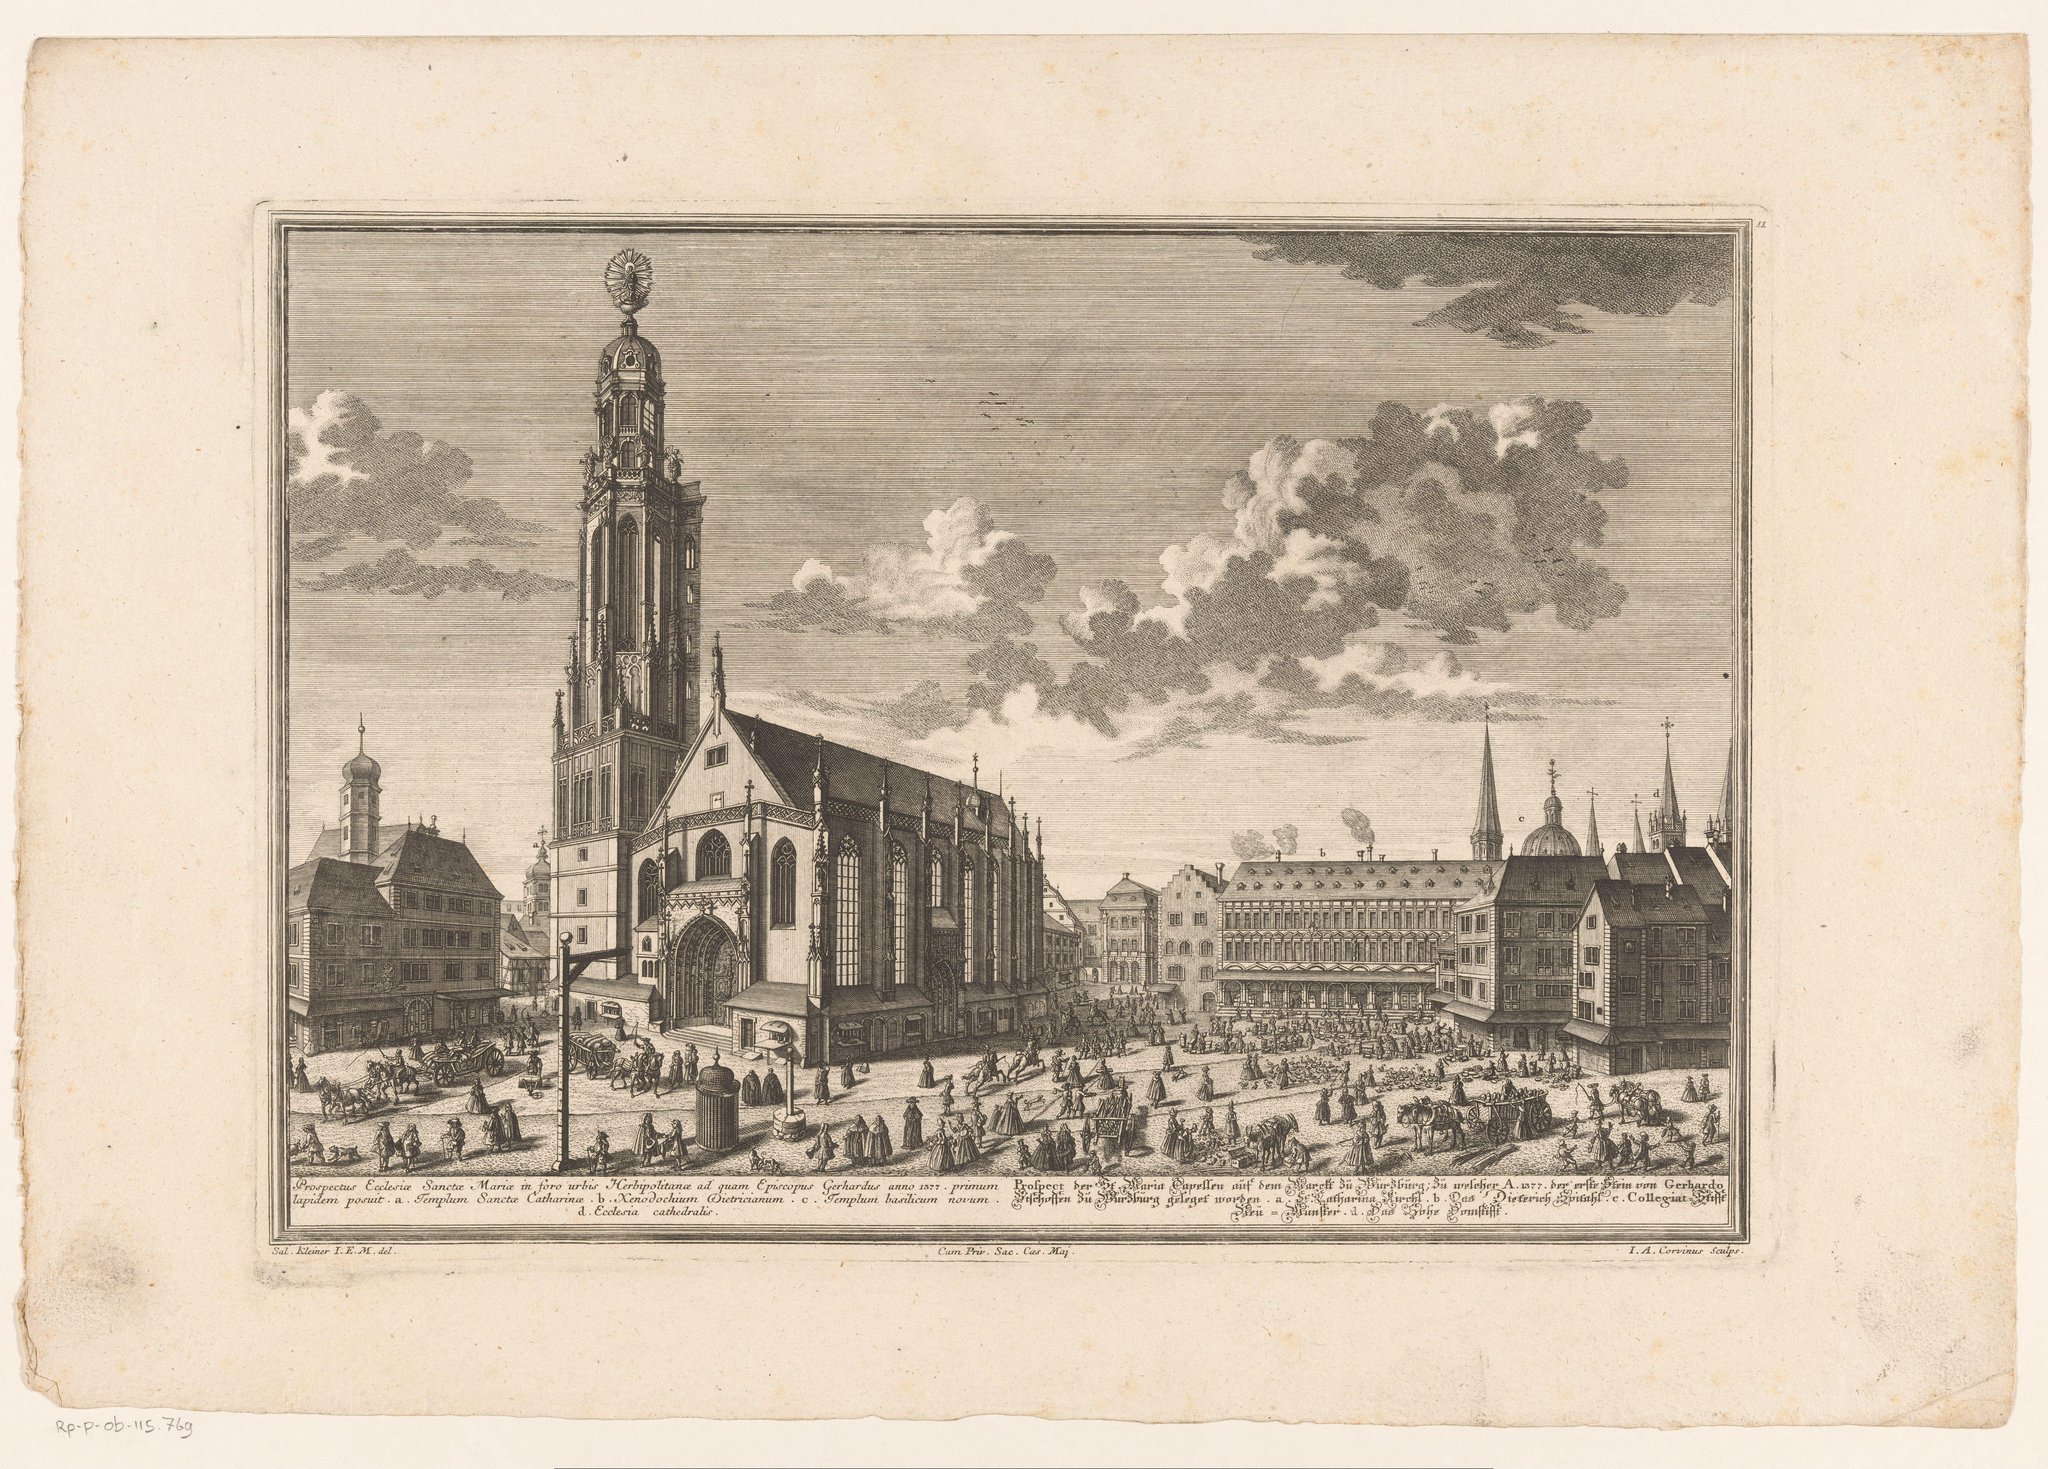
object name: print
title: Ducalis et Episcopalis Residentia Wurzburgum seu Herbipolis in Franconia (...) / Hoch-Fürstlich und Bischöffliche Residenz-Stadt Würzburg in Francken (...)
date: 1740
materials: paper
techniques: engraving, etching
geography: augsburg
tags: city-view, and landscape with man-made constructions, church (exterior), market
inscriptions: collector's mark: Lugt 2228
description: Serie bestaande uit elf prenten plus een titelprent. Johann Andreas Pfeffel wordt op de titelprent aangeduid als prentmaker, maar zijn naam staat op de prenten niet vermeld.